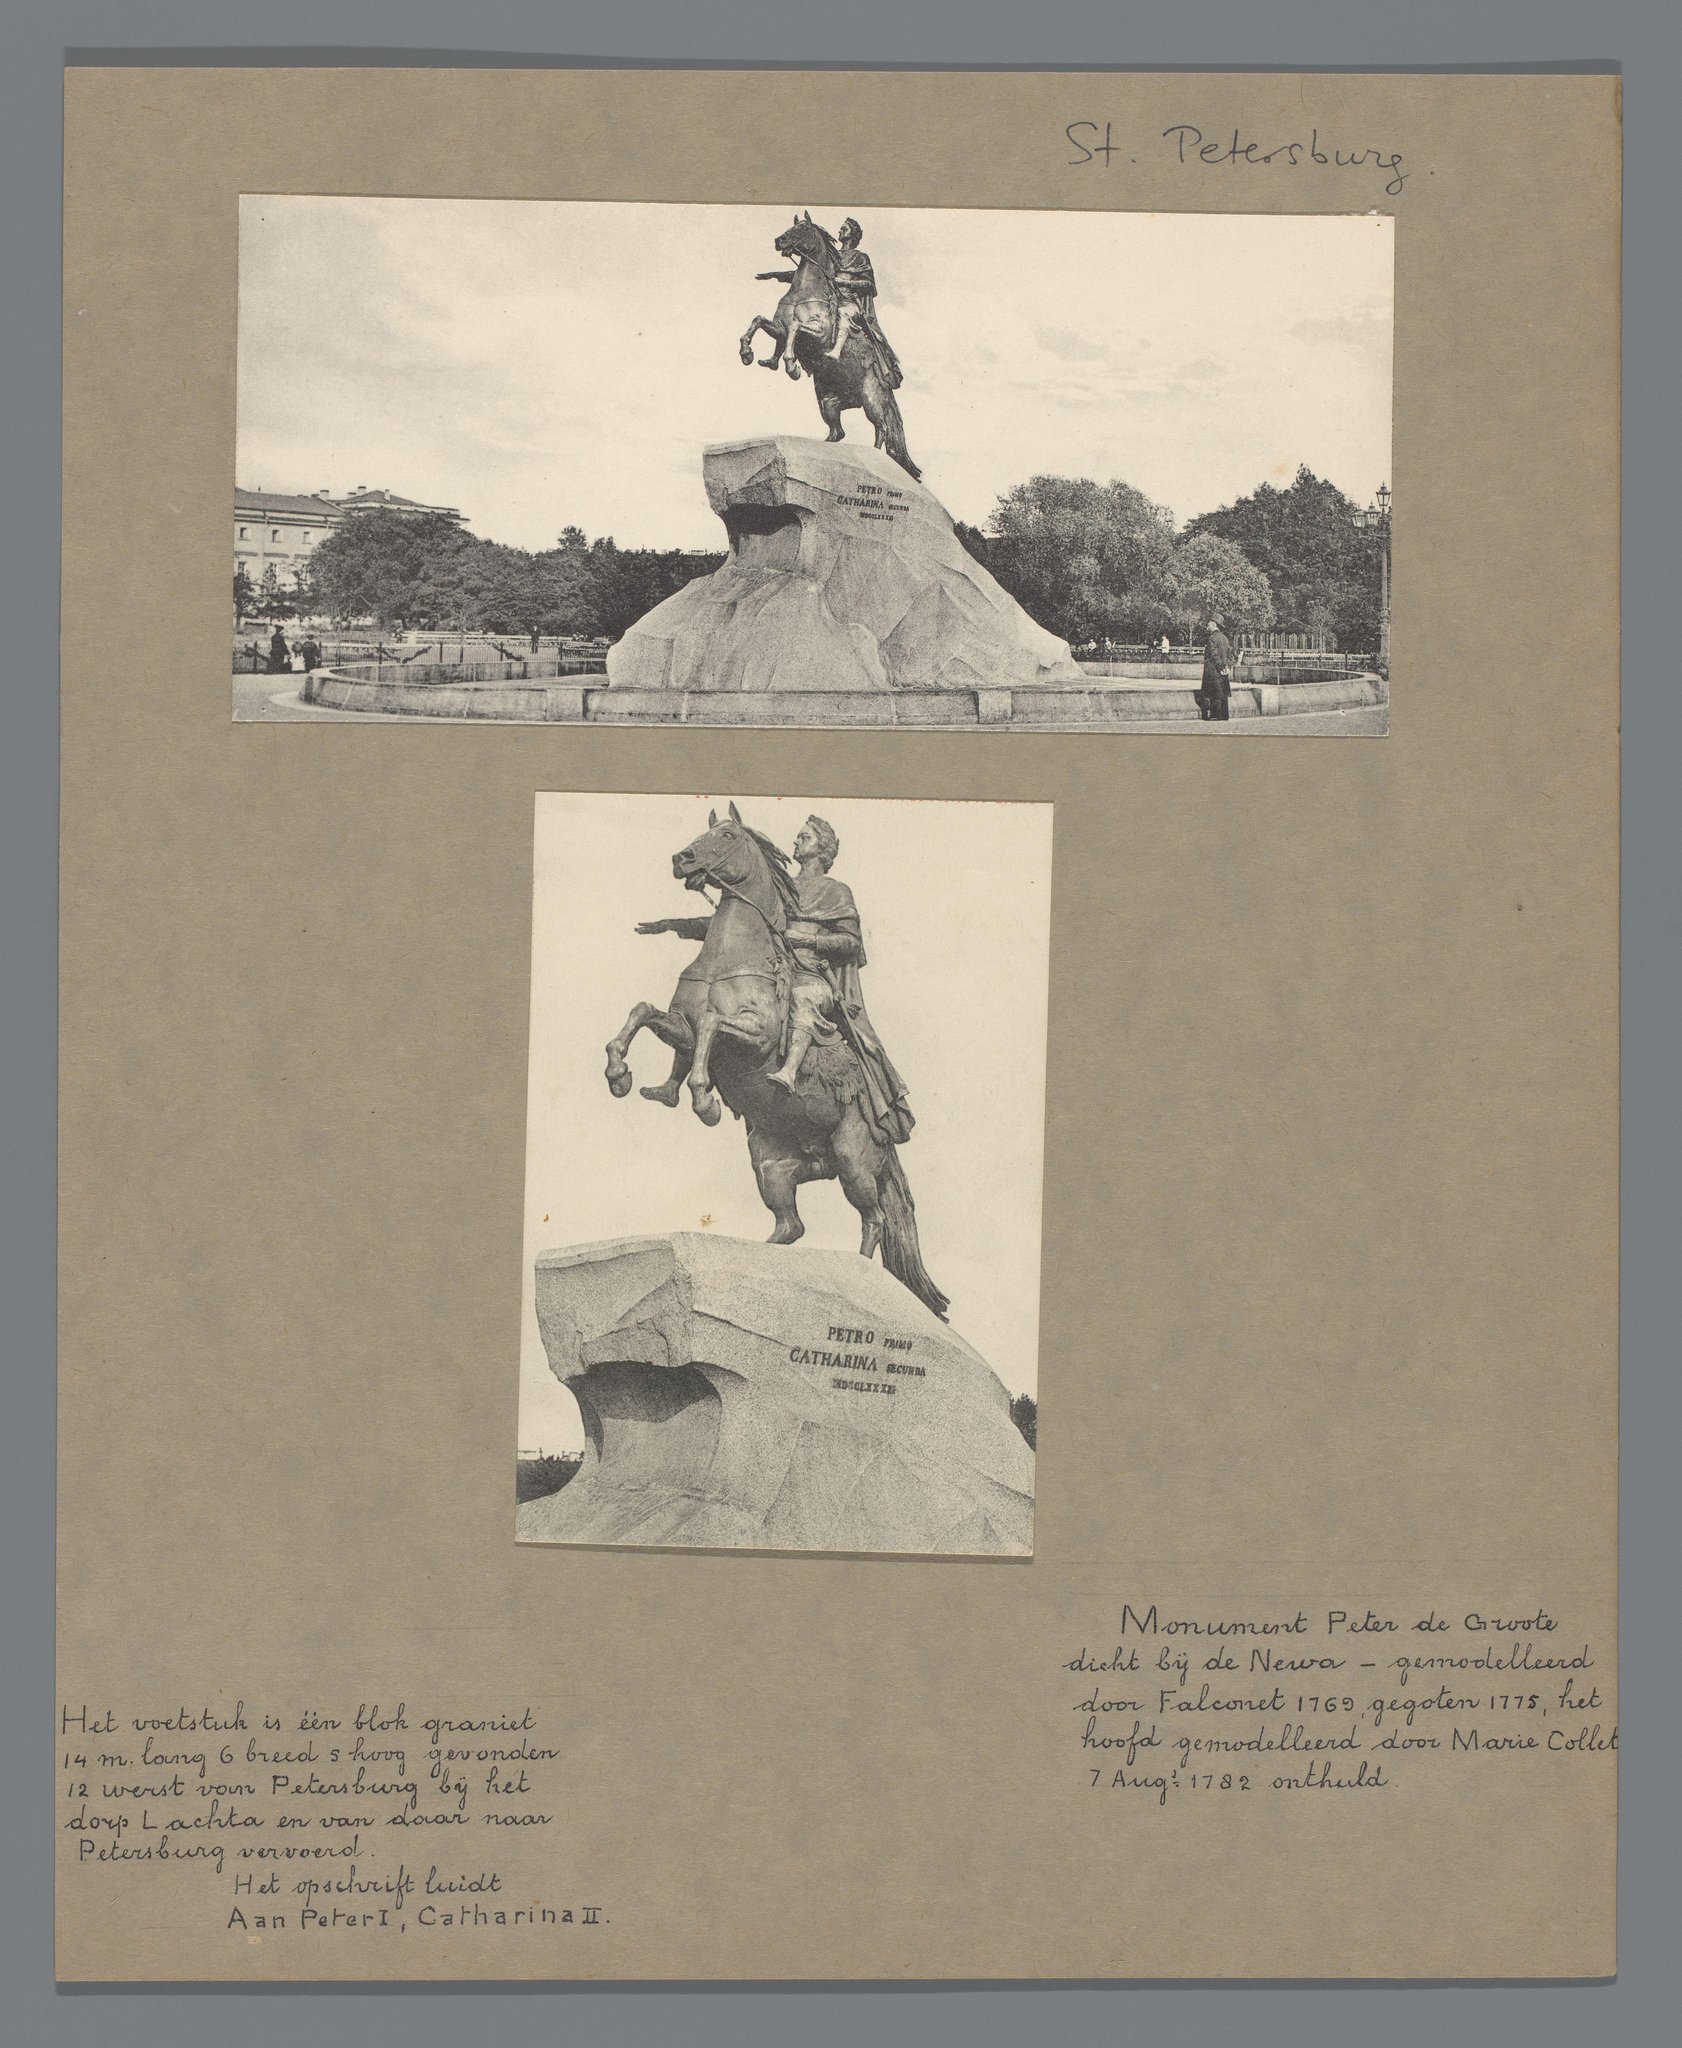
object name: photograph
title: St. Petersburg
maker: Anonymous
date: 1860-1925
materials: photographic support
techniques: photograph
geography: russia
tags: sint-petersburg